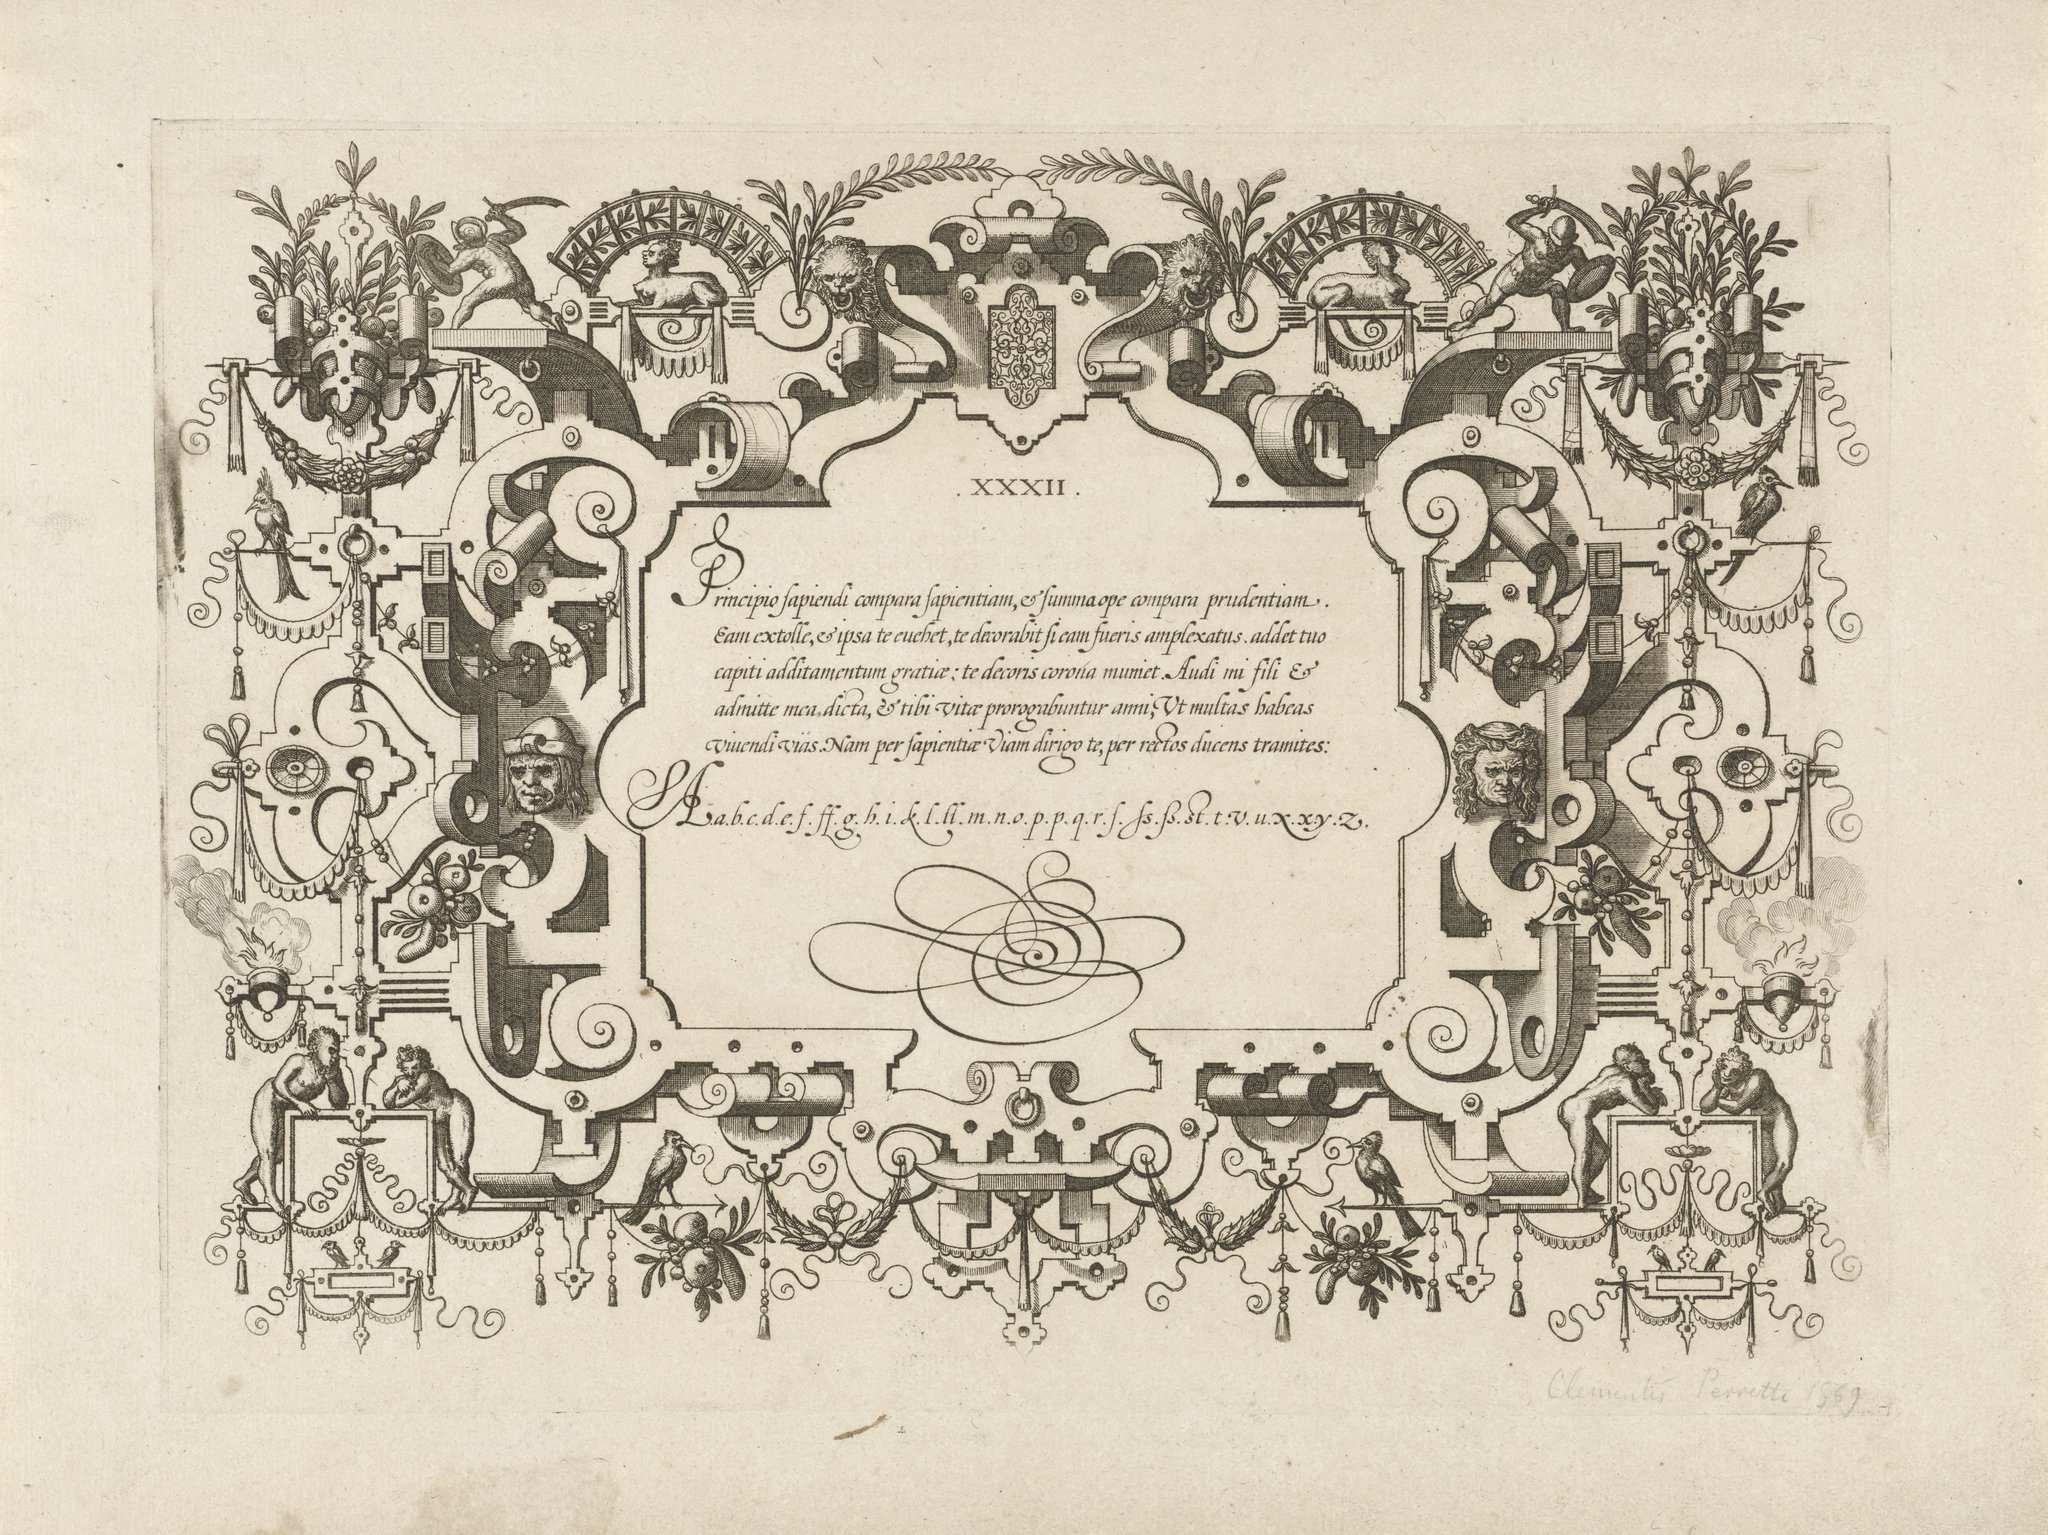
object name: ornament print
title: Exercitatio alphabetica nova et utilissim (...)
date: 1569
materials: paper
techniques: etching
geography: netherlands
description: Blad XXXII. Uit serie van 21 genummerde cartouches met kalligrafie in een omlijsting van rol- en beslagwerk met grotesken, guirlandes en mascarons .